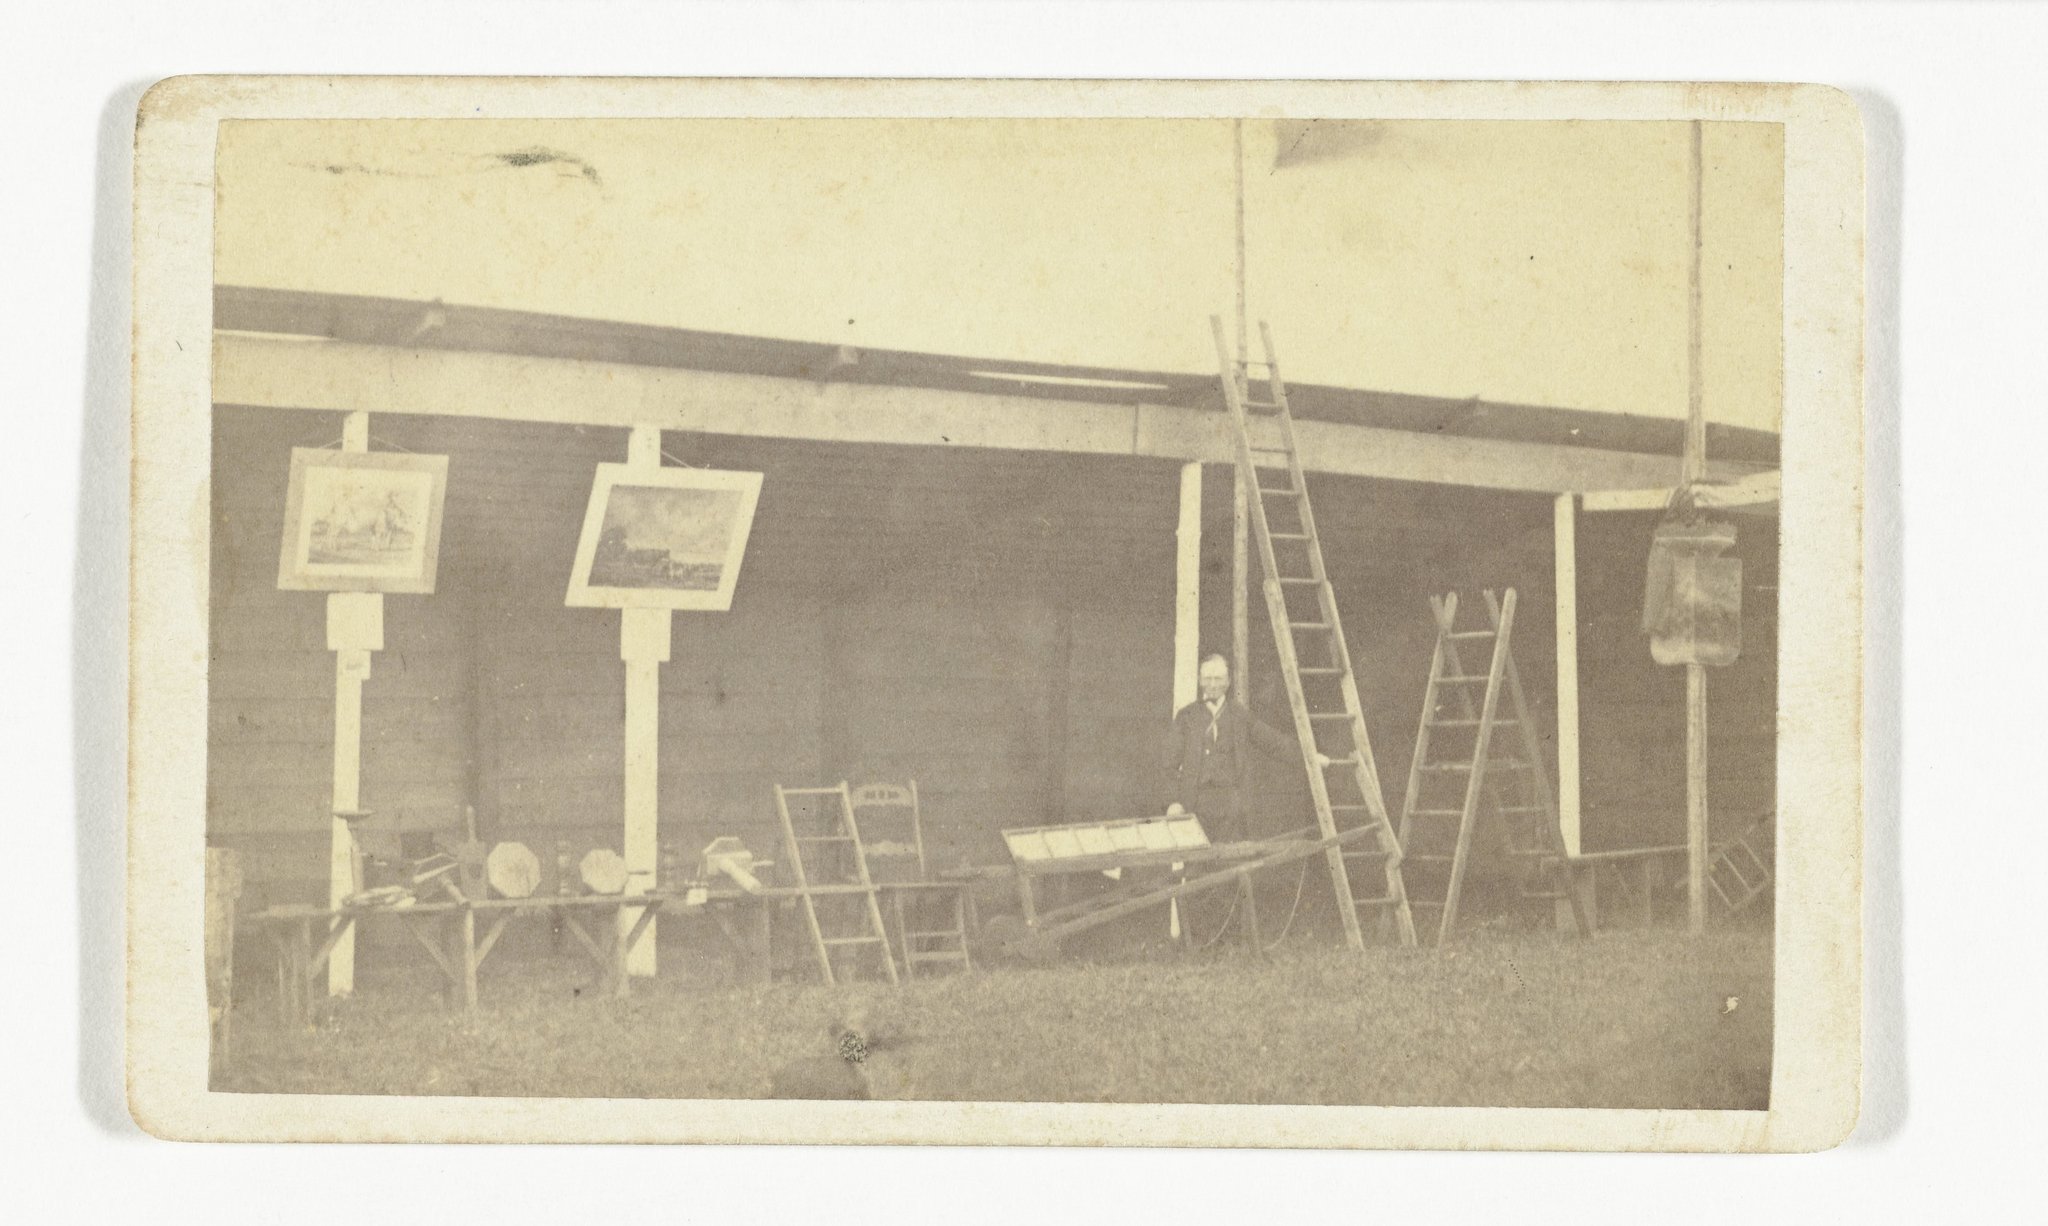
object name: photograph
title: Gezicht op een landbouwtentoonstelling in Middelburg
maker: jan wendel gerstenhauer zimmerman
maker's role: draughtsman, print maker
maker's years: 1816-1887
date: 1862-1870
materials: cardboard, photographic support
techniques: albumen print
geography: middelburg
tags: collection, exhibition, show, agriculture, middelburg